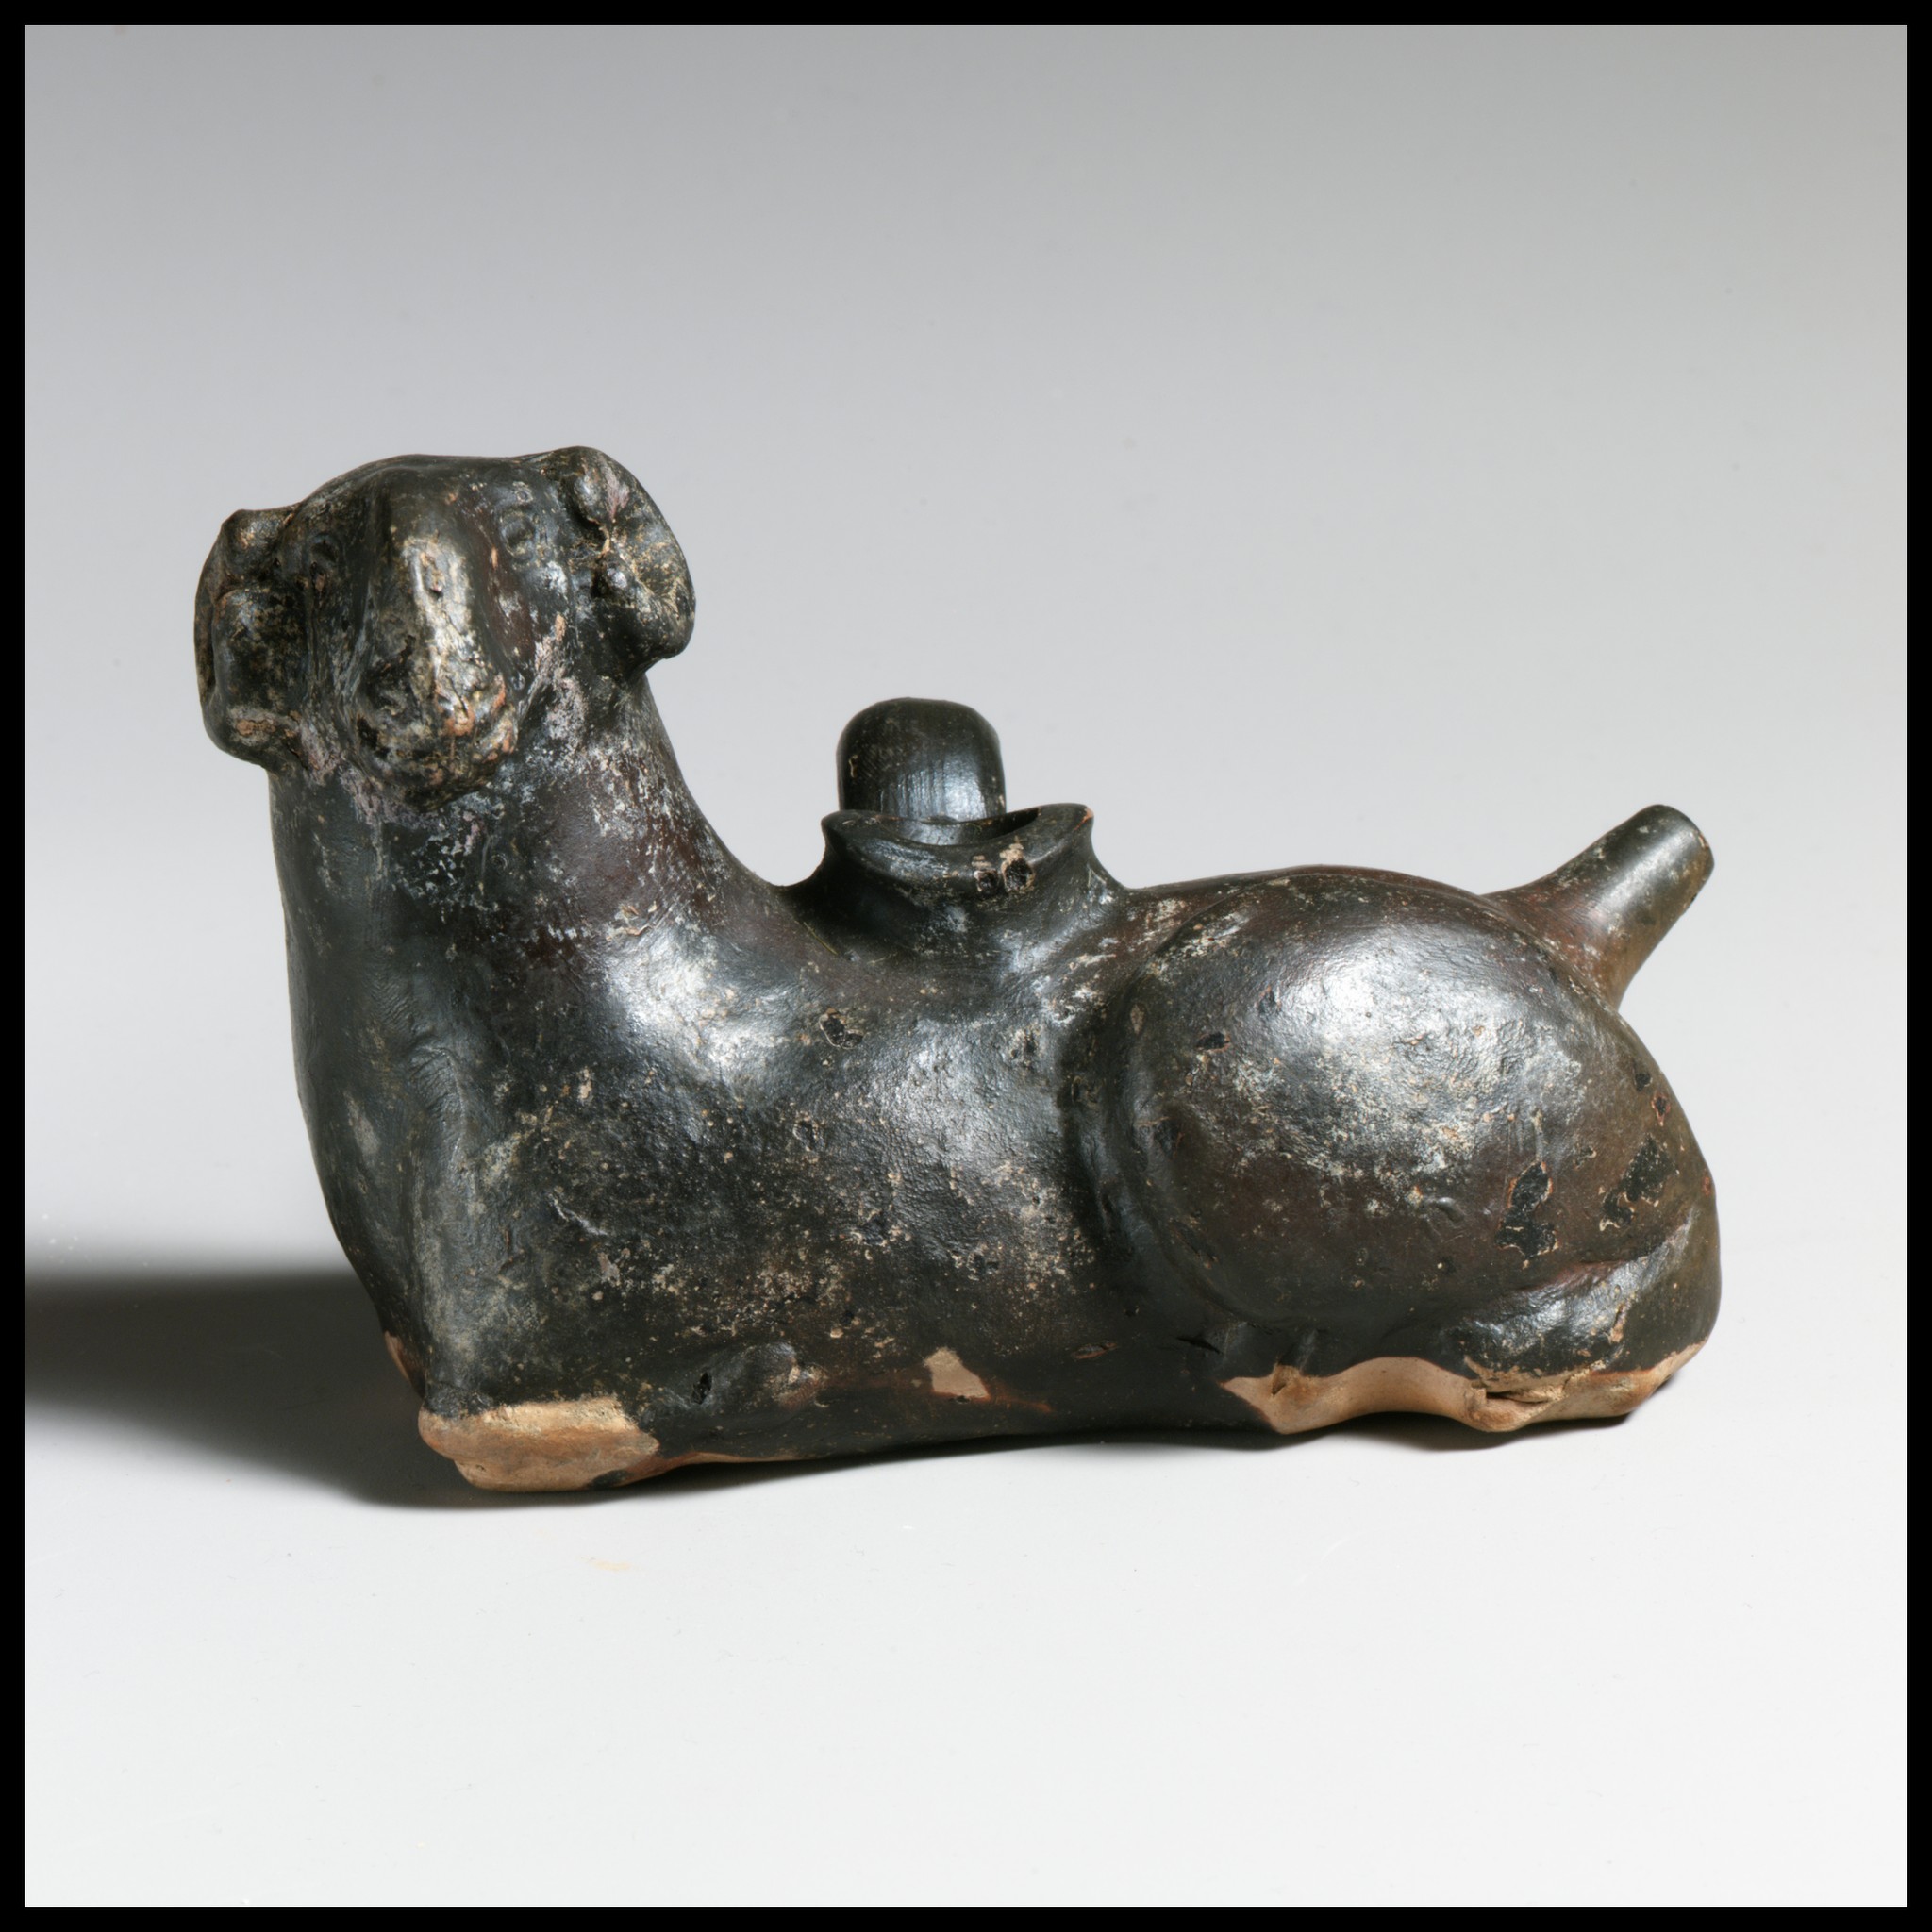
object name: vase in the form of a ram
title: Terracotta vase in the form of a ram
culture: greek or south italian or campanian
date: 400-301 BCE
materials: terracotta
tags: rams